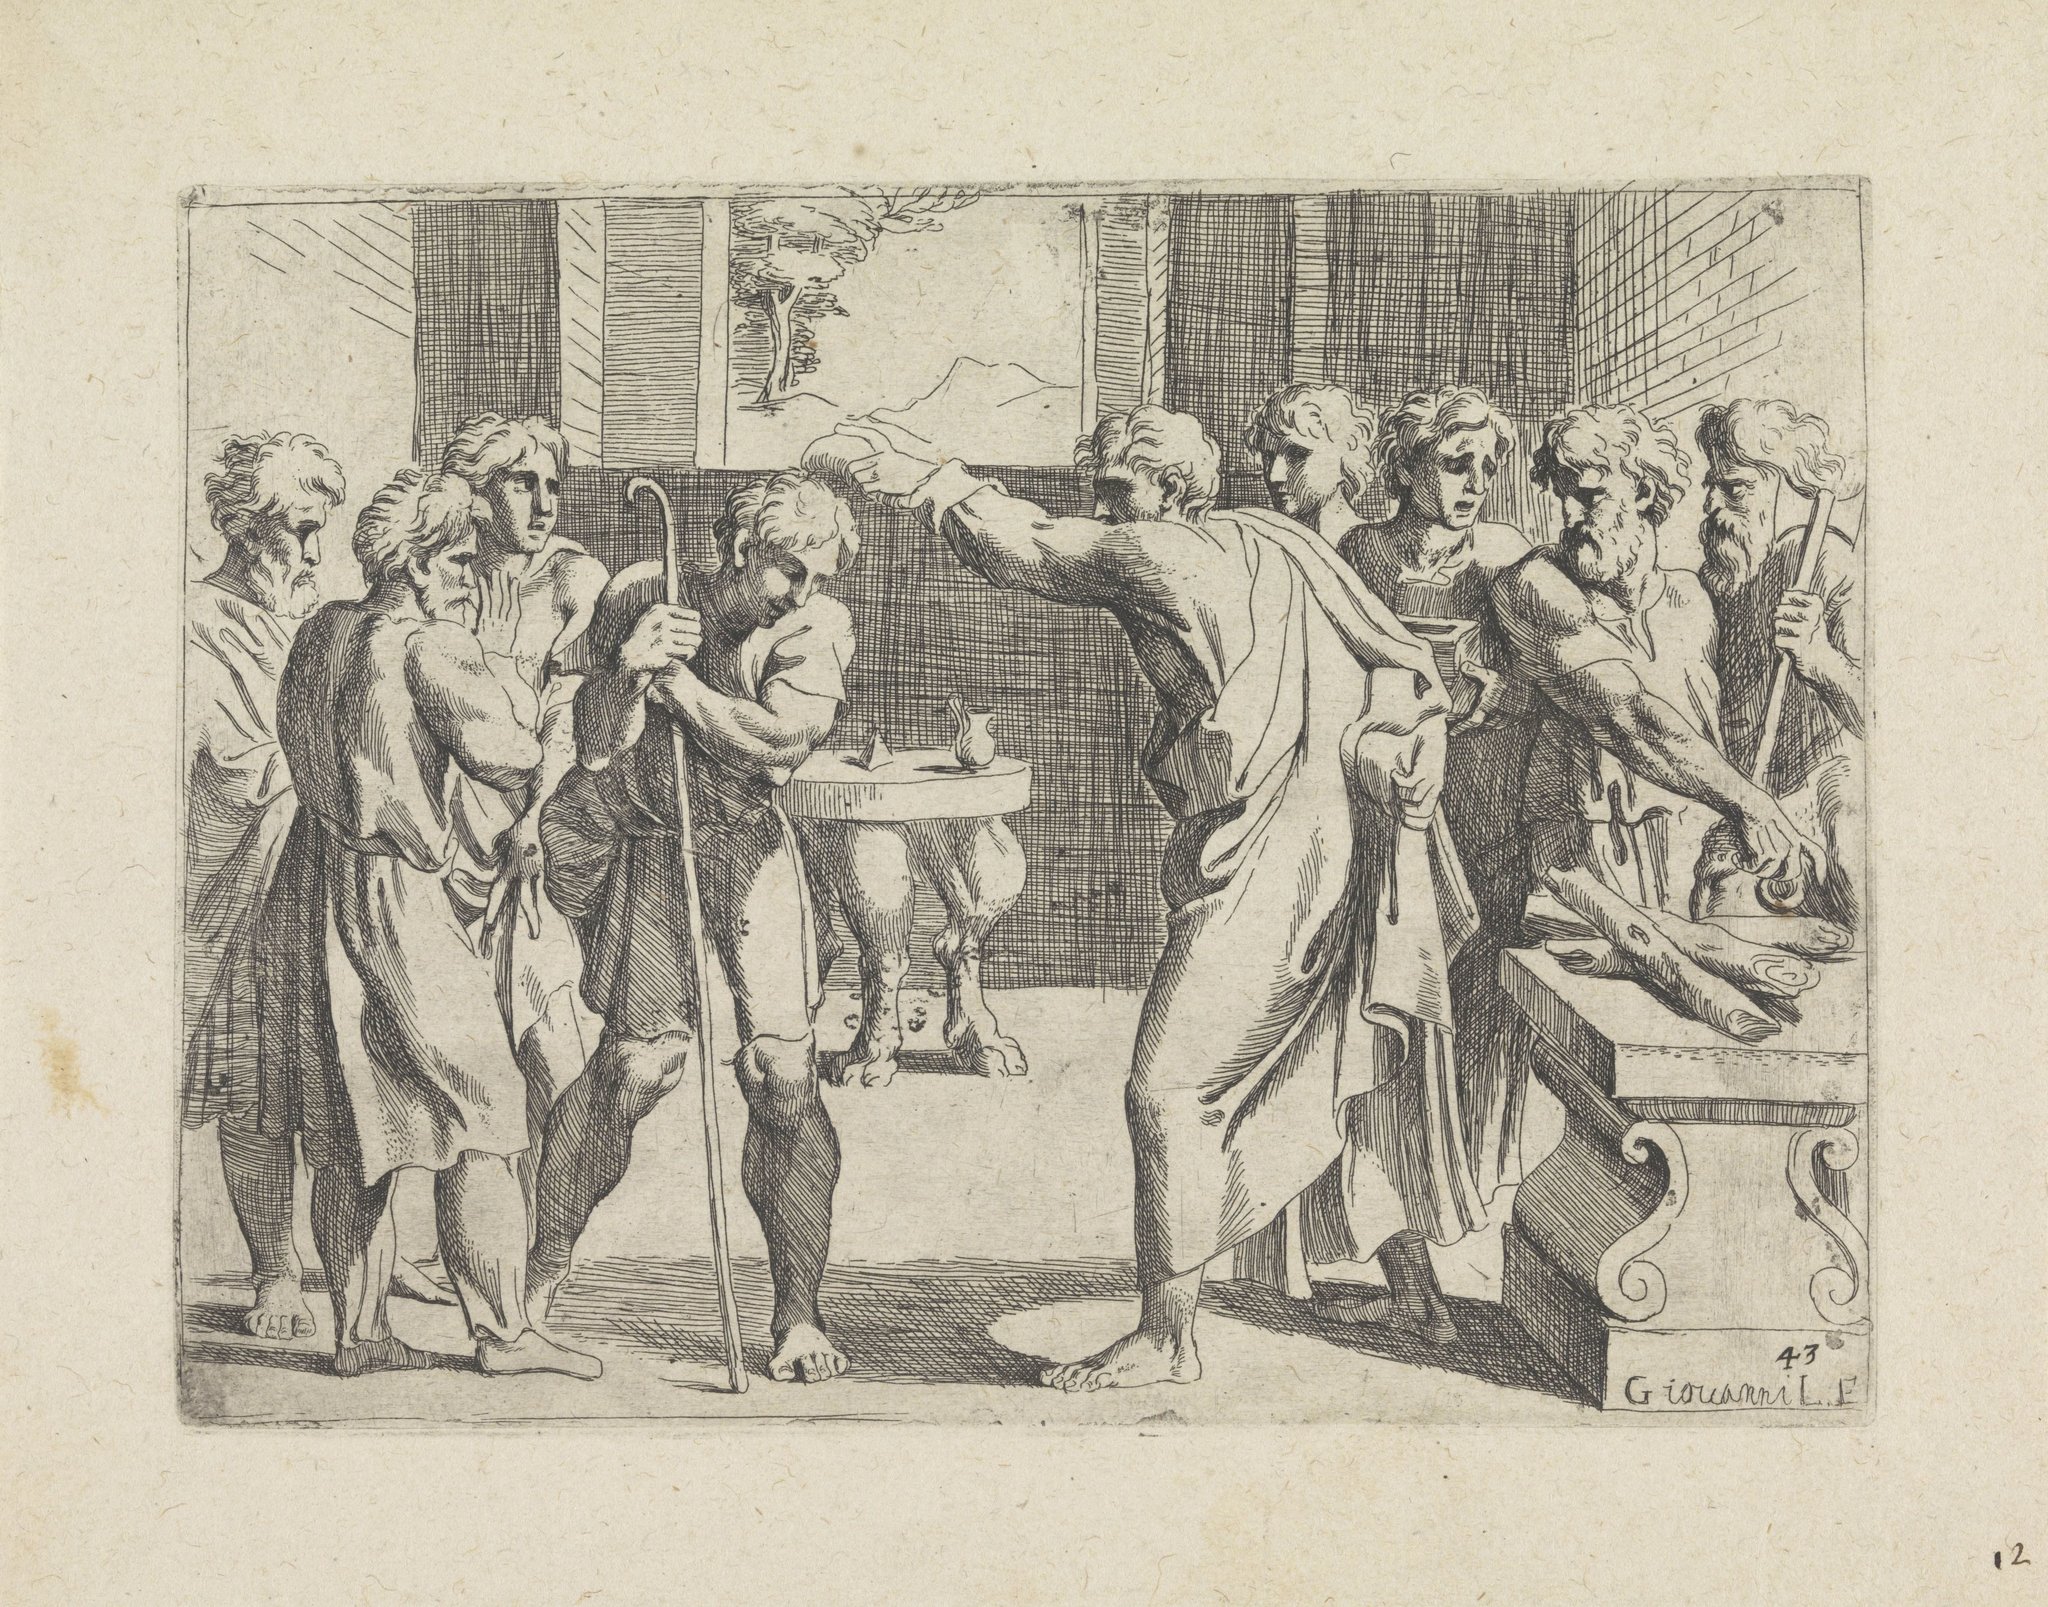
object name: print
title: Historia del Testamento Vecchio / Dipinta in Roma nel Vaticano da Raffaelle di Urbin (...)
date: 1607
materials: paper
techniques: etching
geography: italy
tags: samuel anointing david in the presence of his father jesse and his brothers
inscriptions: collector's mark: Lugt 11, number: ‘12’, collector's mark: ‘Hinloopen’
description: Op een blad geplakt met rechtsboven handgeschreven in pen in bruin: 132. Prent uit een reeks van 54 genummerde prenten naar schilderingen in de Loggia van Rafael in het Vaticaan.